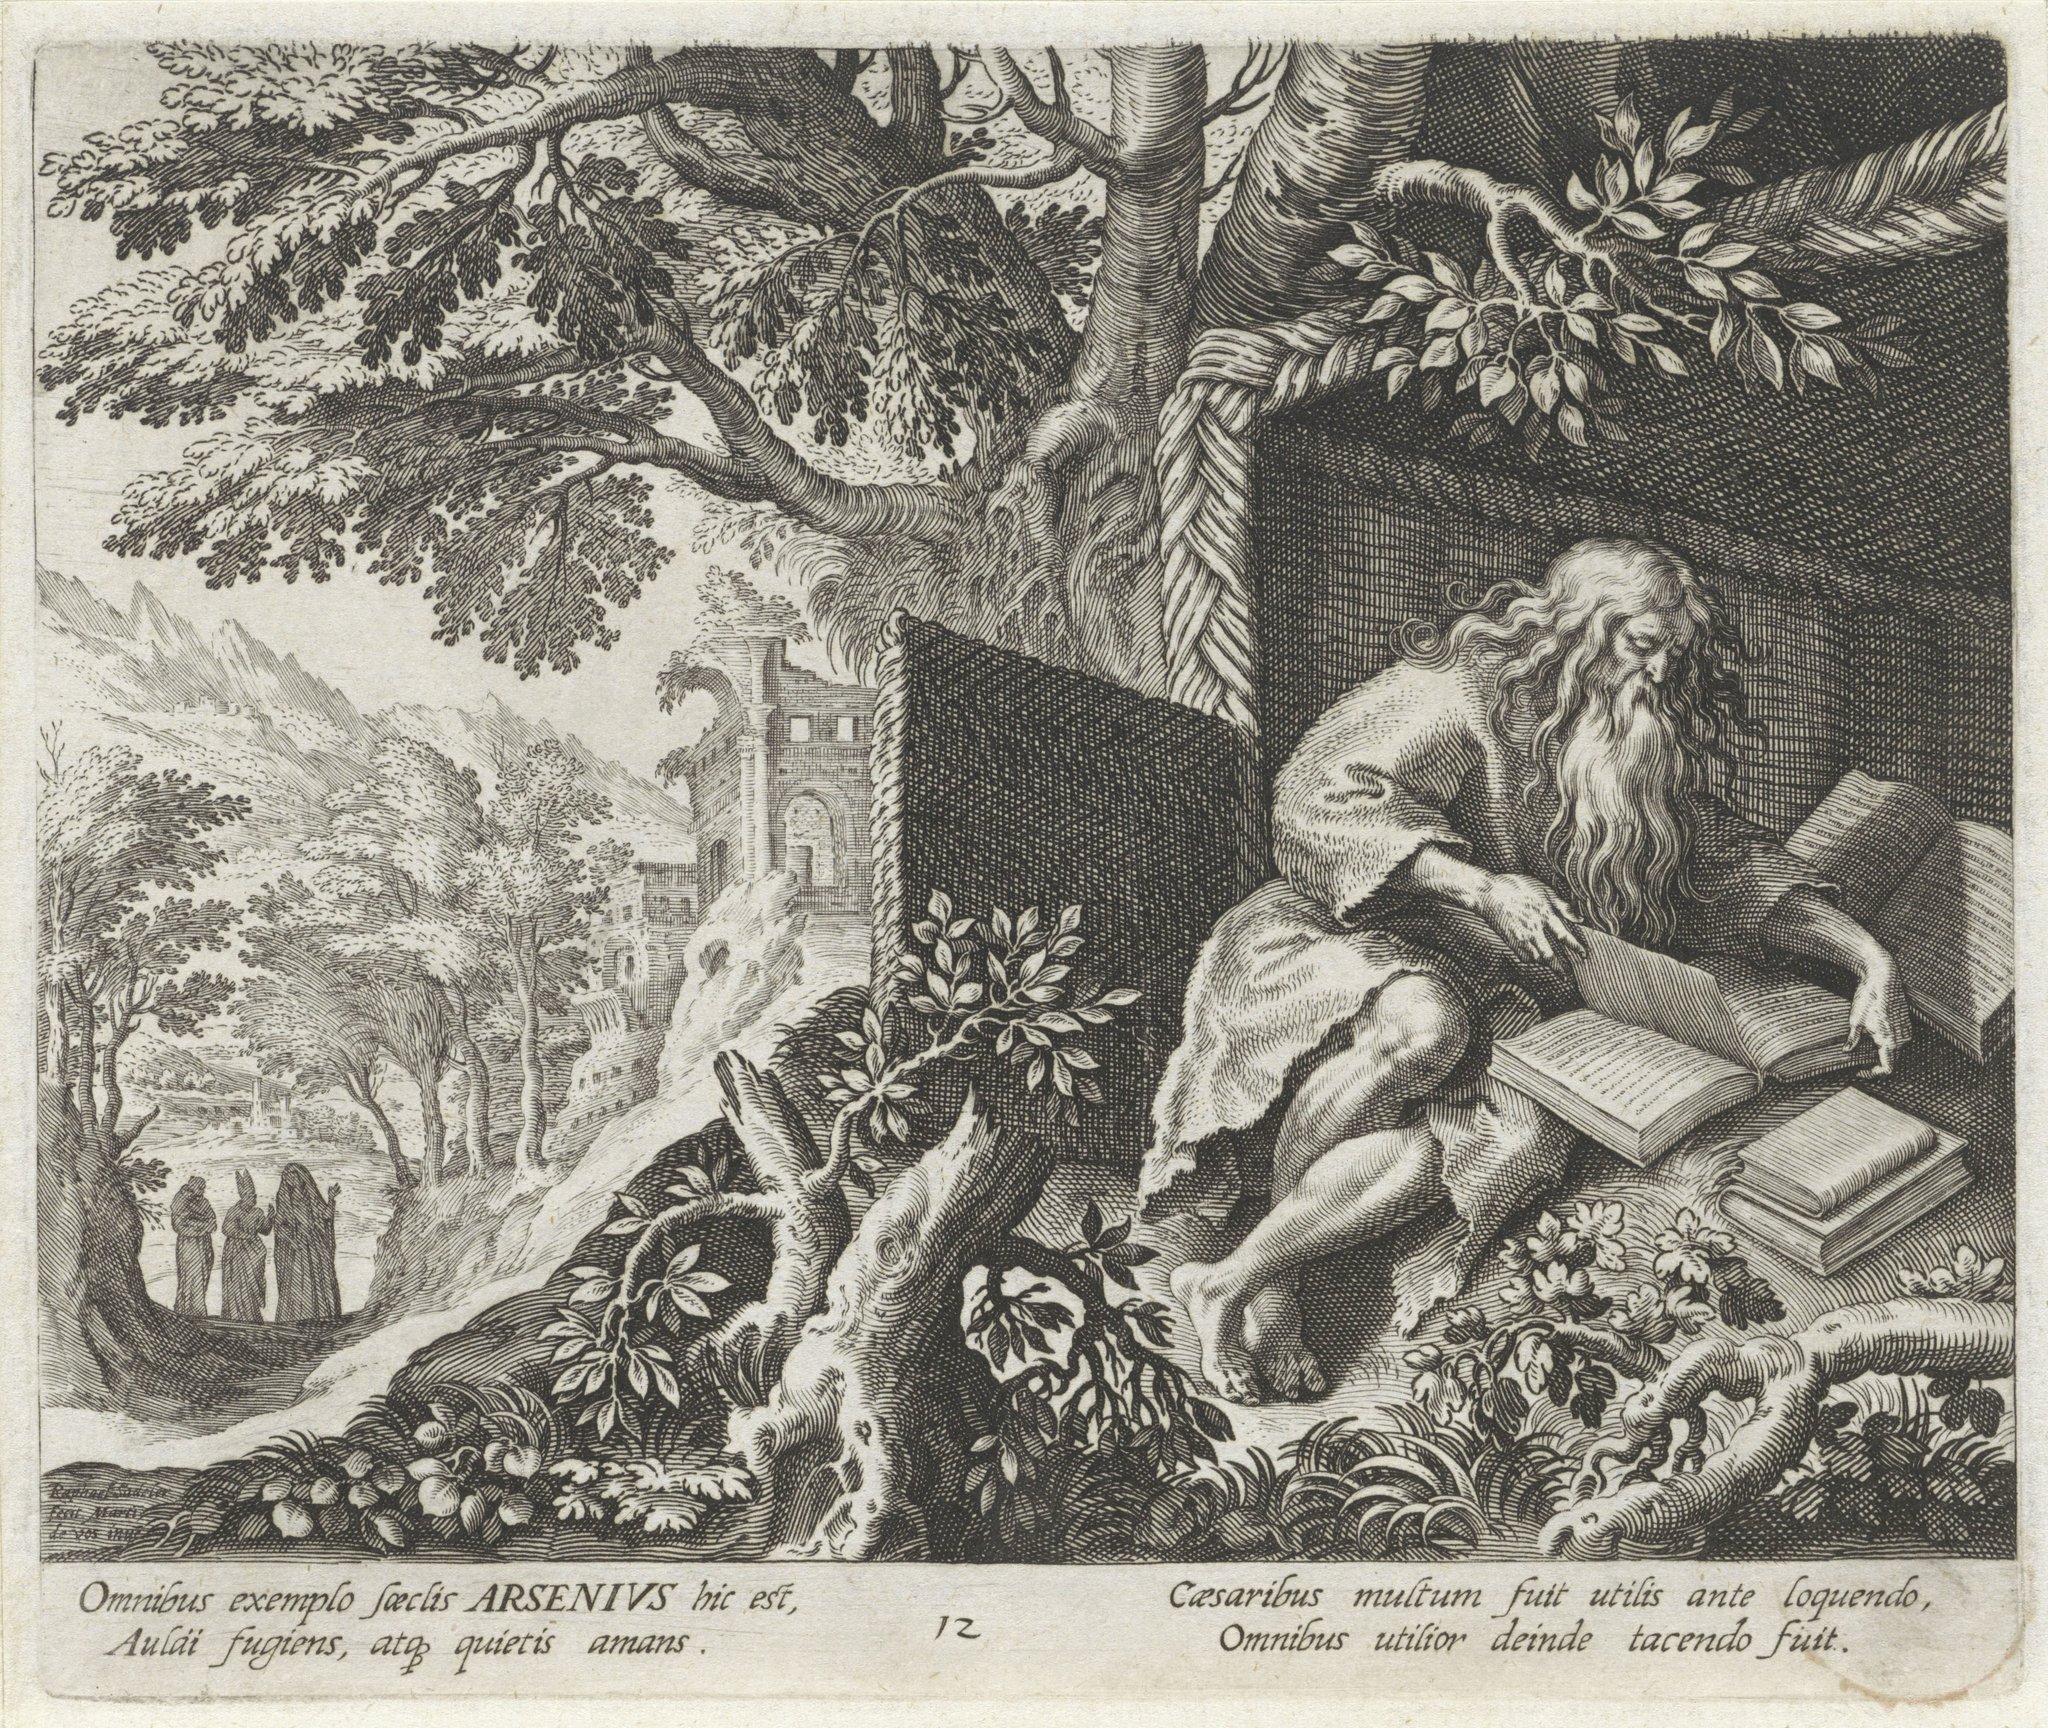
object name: print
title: Mannelijke kluizenaars en heremieten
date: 1594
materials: paper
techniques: engraving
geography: munich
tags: male saints (with name), anchorite, hermit, landscape with ruins (+ city(-scape) with figures, staffage), hermitage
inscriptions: collector's mark: Lugt 240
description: H. Arsenius de Grote, een vroeg-christelijke kluizenaar in de woestijn van Lybië. Hij ligt in een hut en leest een bijbel. Op de achtergrond naderen drie vrouwen op een landweg.